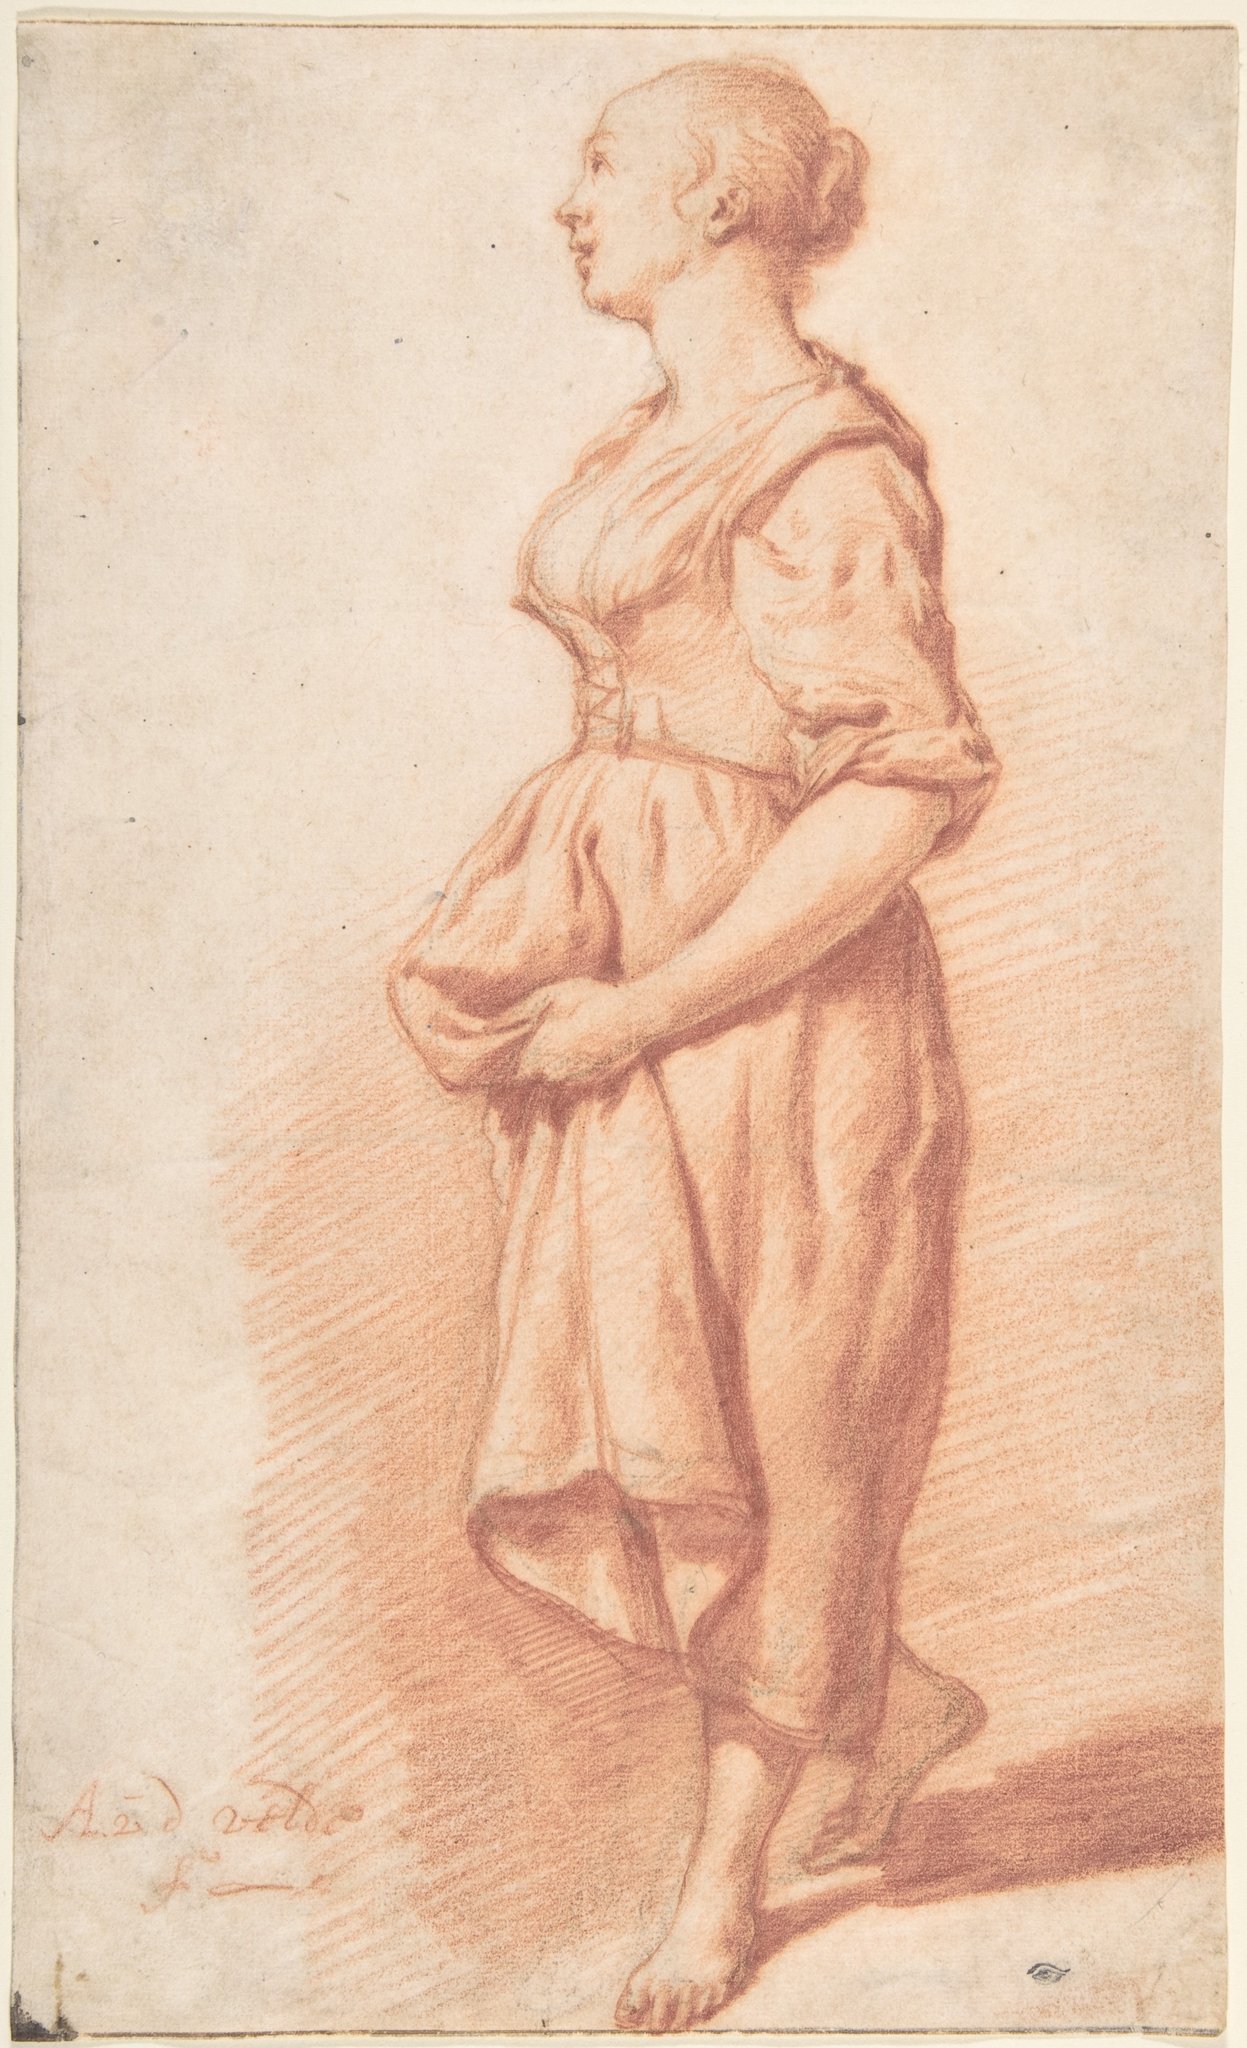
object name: drawing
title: A Young Girl Walking to the Left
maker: adriaen van de velde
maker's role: artist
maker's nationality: dutch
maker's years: 1636-1672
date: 1634-1666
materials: chalk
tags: girls,walking